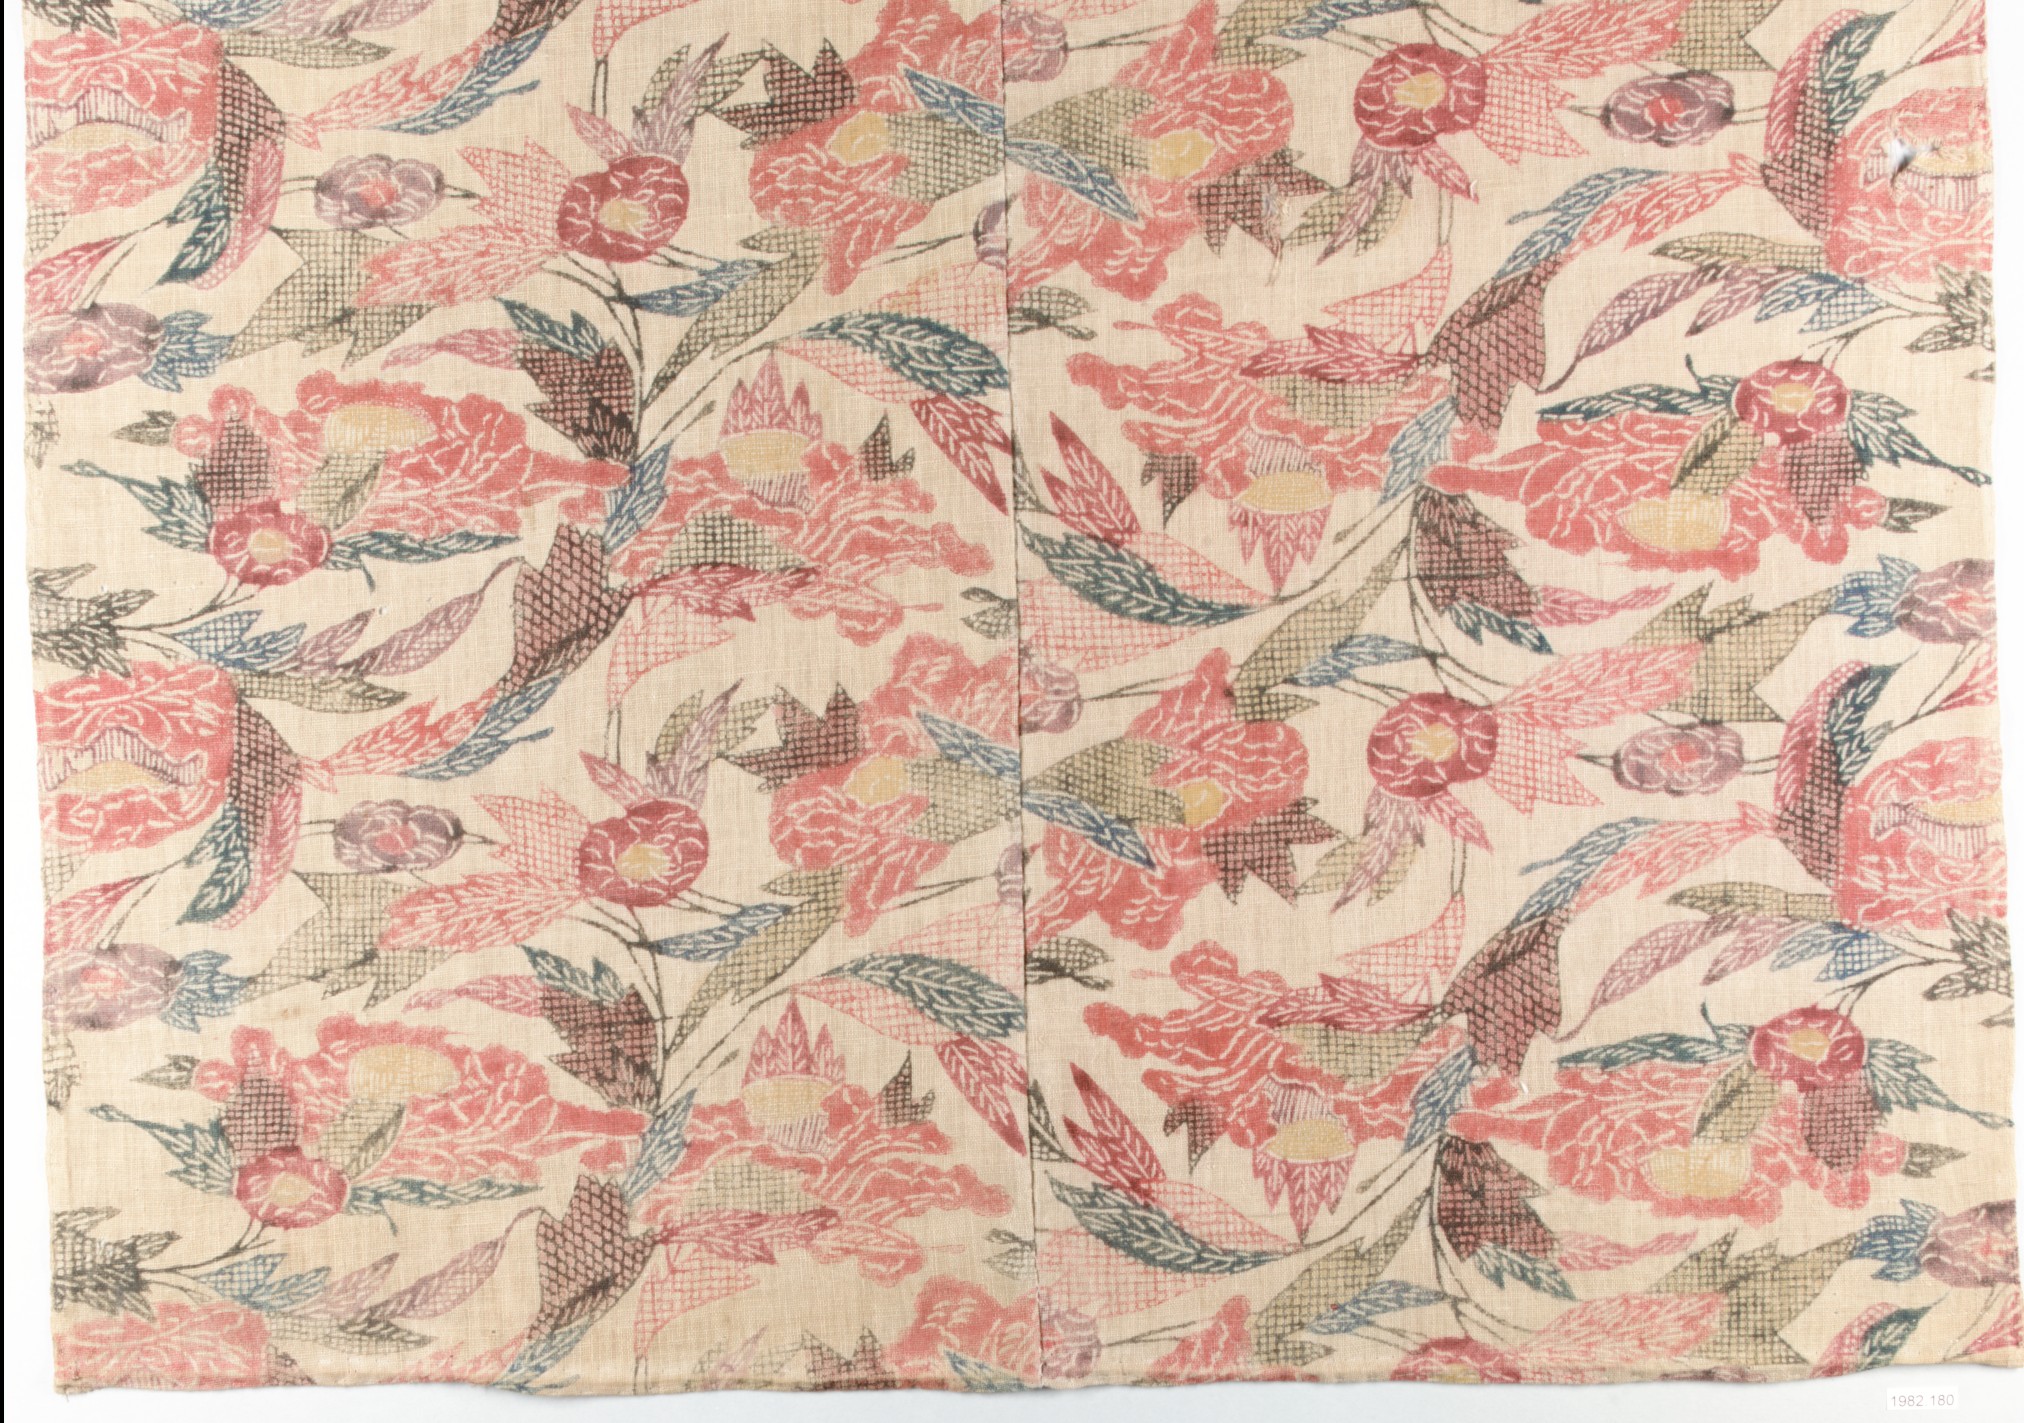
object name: piece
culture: japanese or ryukyuan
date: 1701-1800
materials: fiber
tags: flowers,leaves